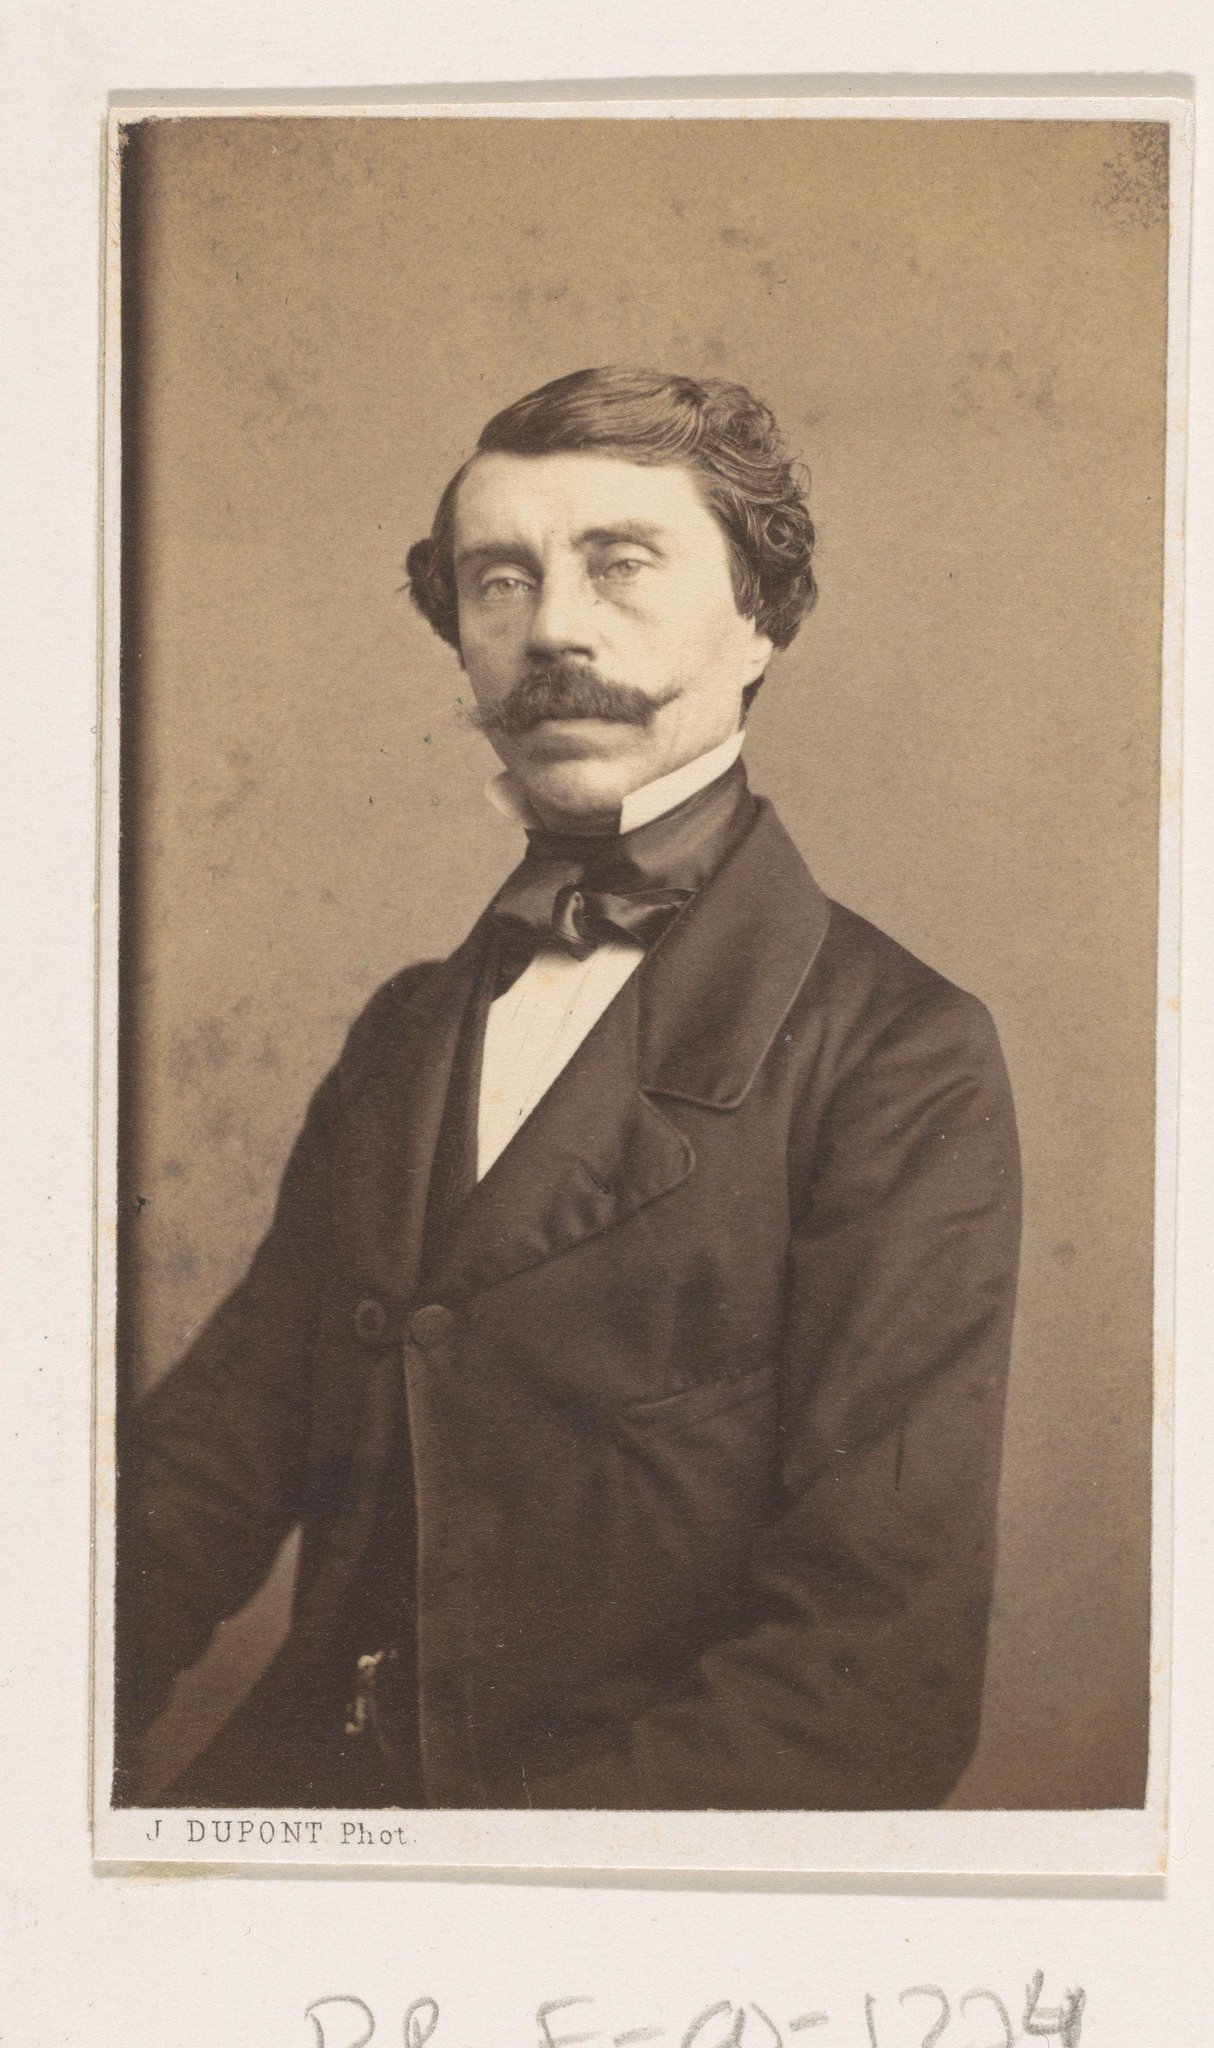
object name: carte de visite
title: Portret van de schilder Jozef Cornelius Correns, halffiguur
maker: joseph dupont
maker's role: fotograaf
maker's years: 1818-1901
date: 1861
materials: cardboard, paper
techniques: albumen print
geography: antwerp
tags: antwerp, painter, draughtsman, jozef cornelius correns, historical persons, portrait, self-portrait of painter, portrait, self-portrait of artist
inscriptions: inscription: ‘Correns (Joseph)/ peintre né à Anvers/ en 1814 Elève de l'ac dernier Royal et de M. Mathieu von Brée’, inscription: ‘ETABLISSEMENT PHOTOGRAPHIQUE/ de/ J. DUPONT/ Place de Meir 32/ ANVERS/ Maison fondée en 1853’